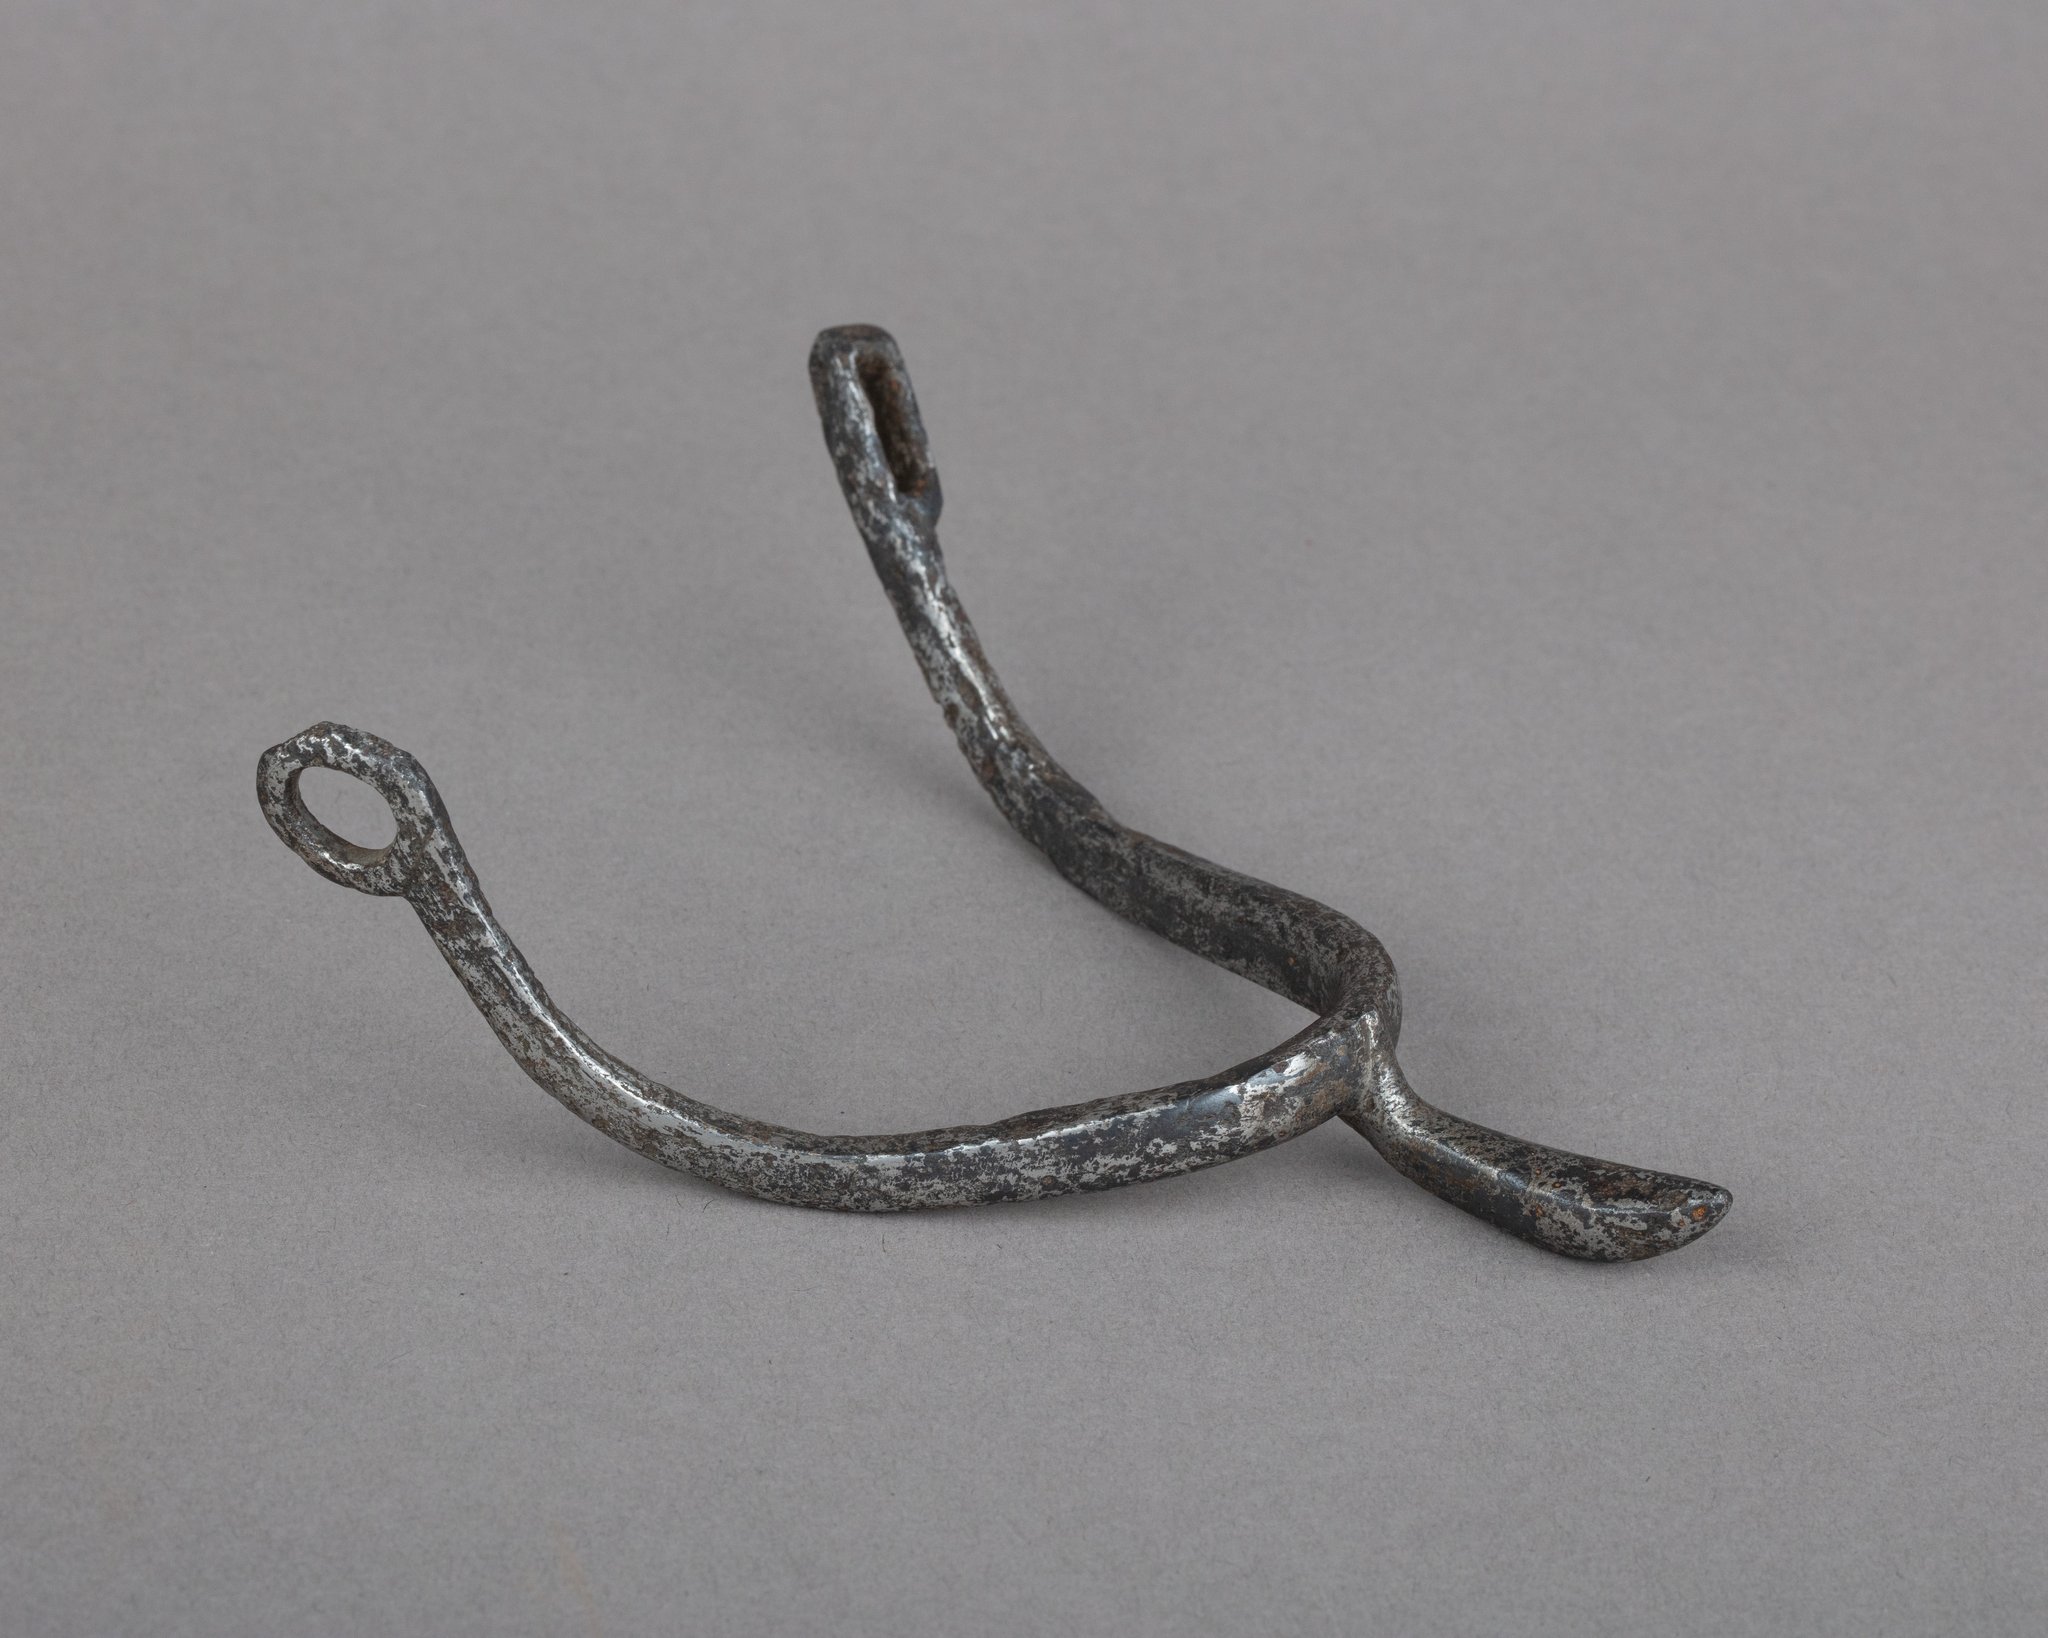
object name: spur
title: Prick Spur (Left)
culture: european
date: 1801-1900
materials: metal alloy